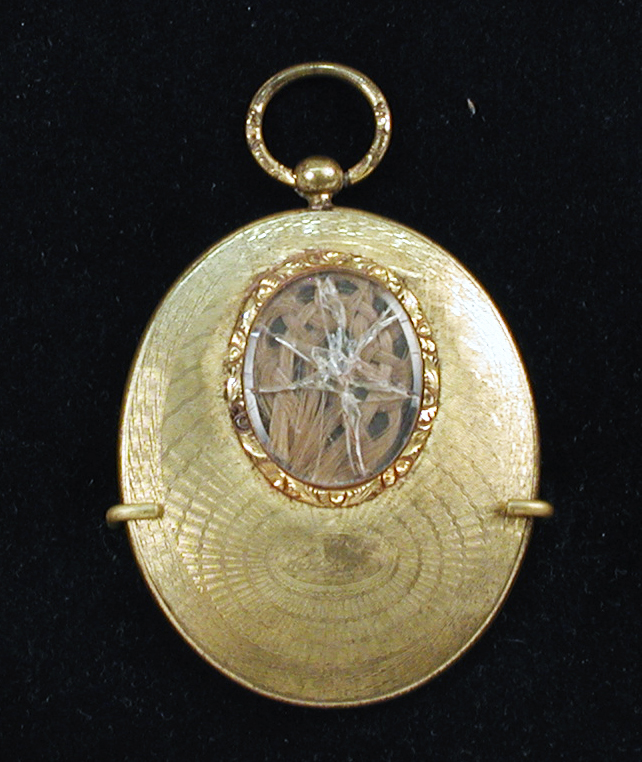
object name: frame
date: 1801-1900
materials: brass, gilt